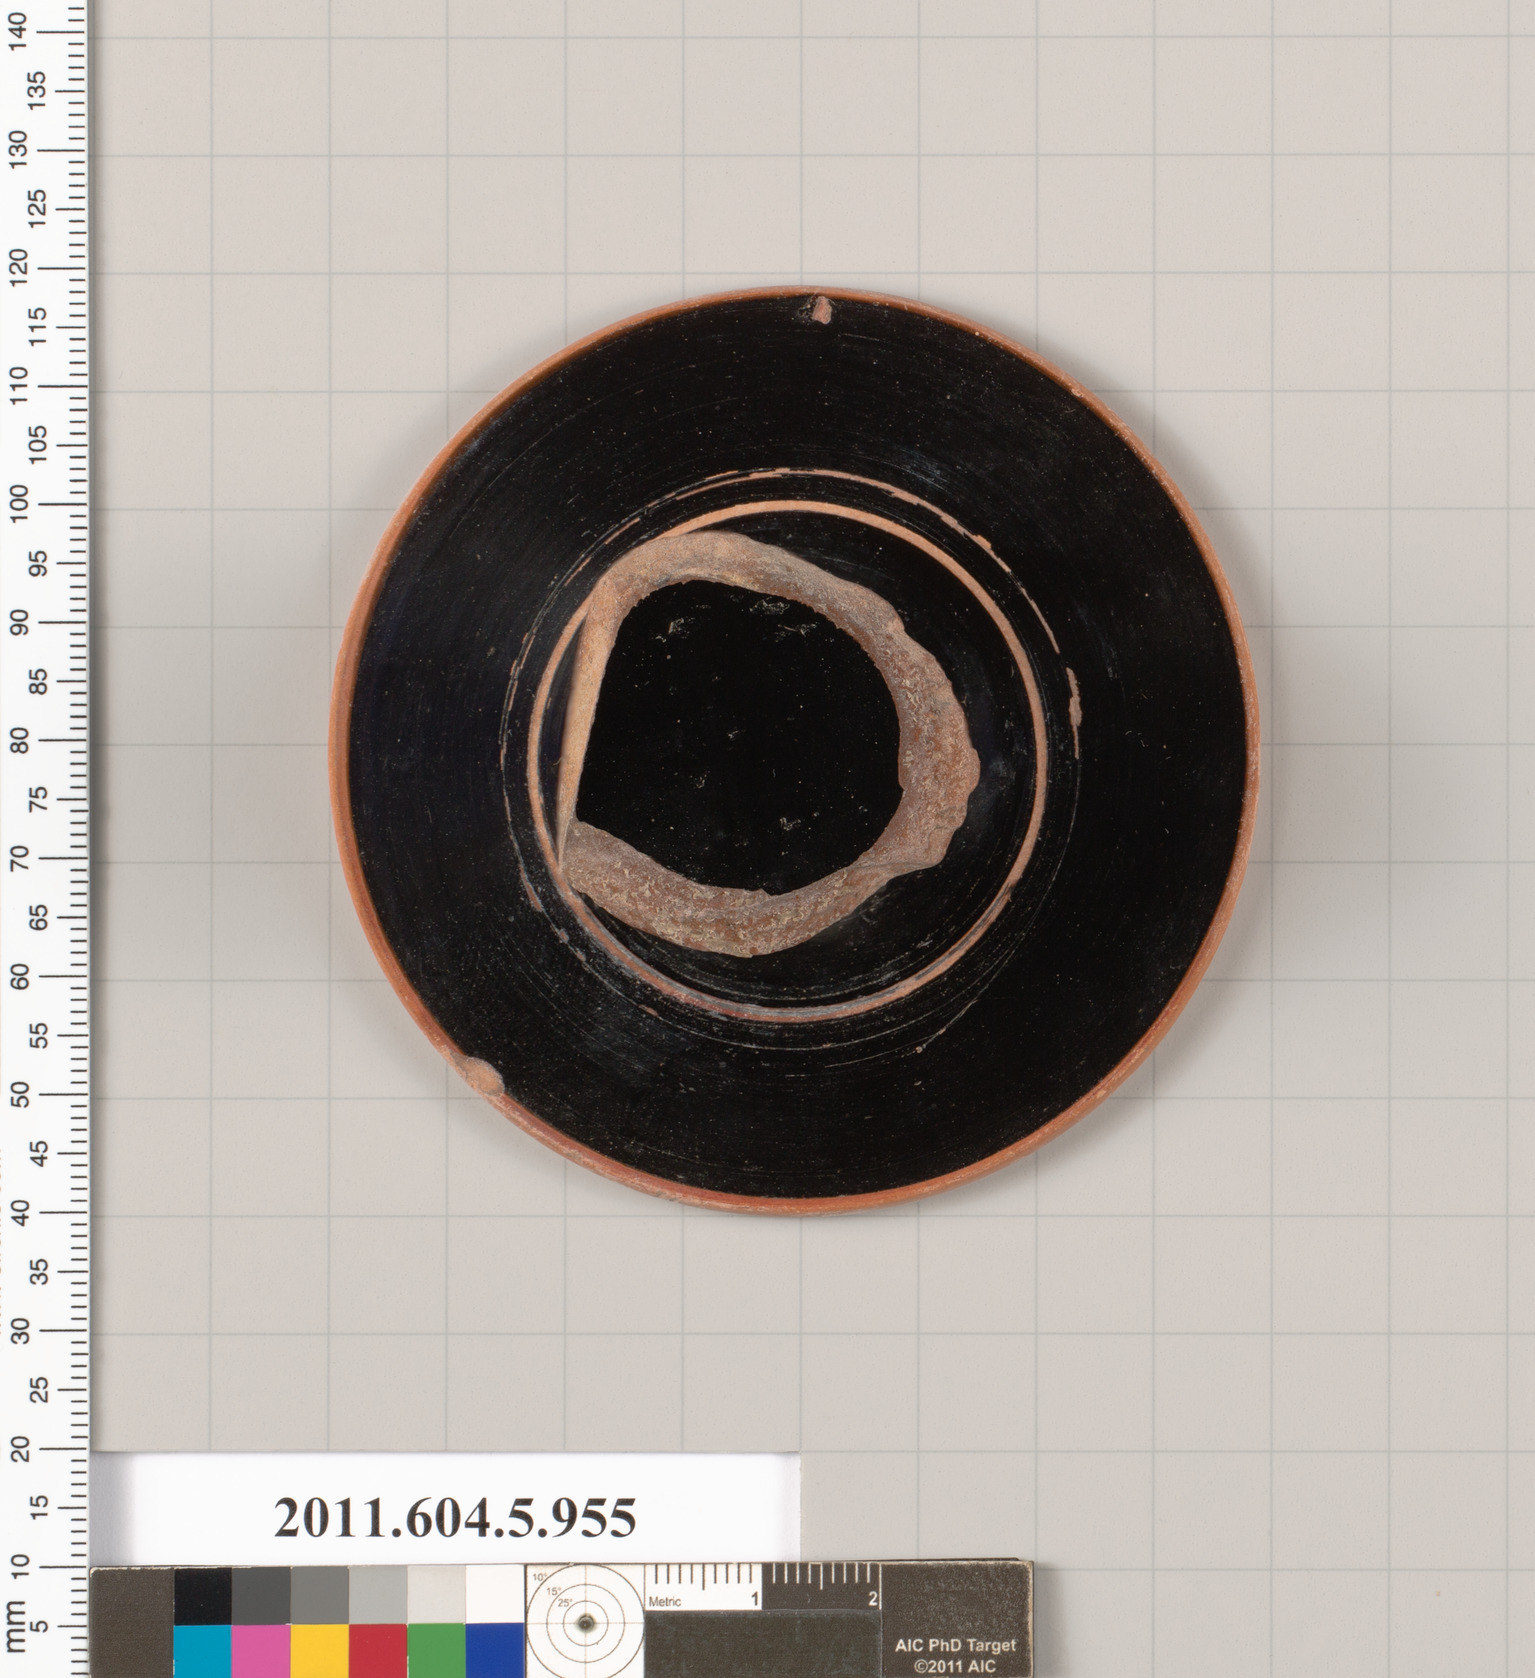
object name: kylix fragment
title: Terracotta fragment of a kylix (drinking cup)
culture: greek, attic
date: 600-401 BCE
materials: terracotta